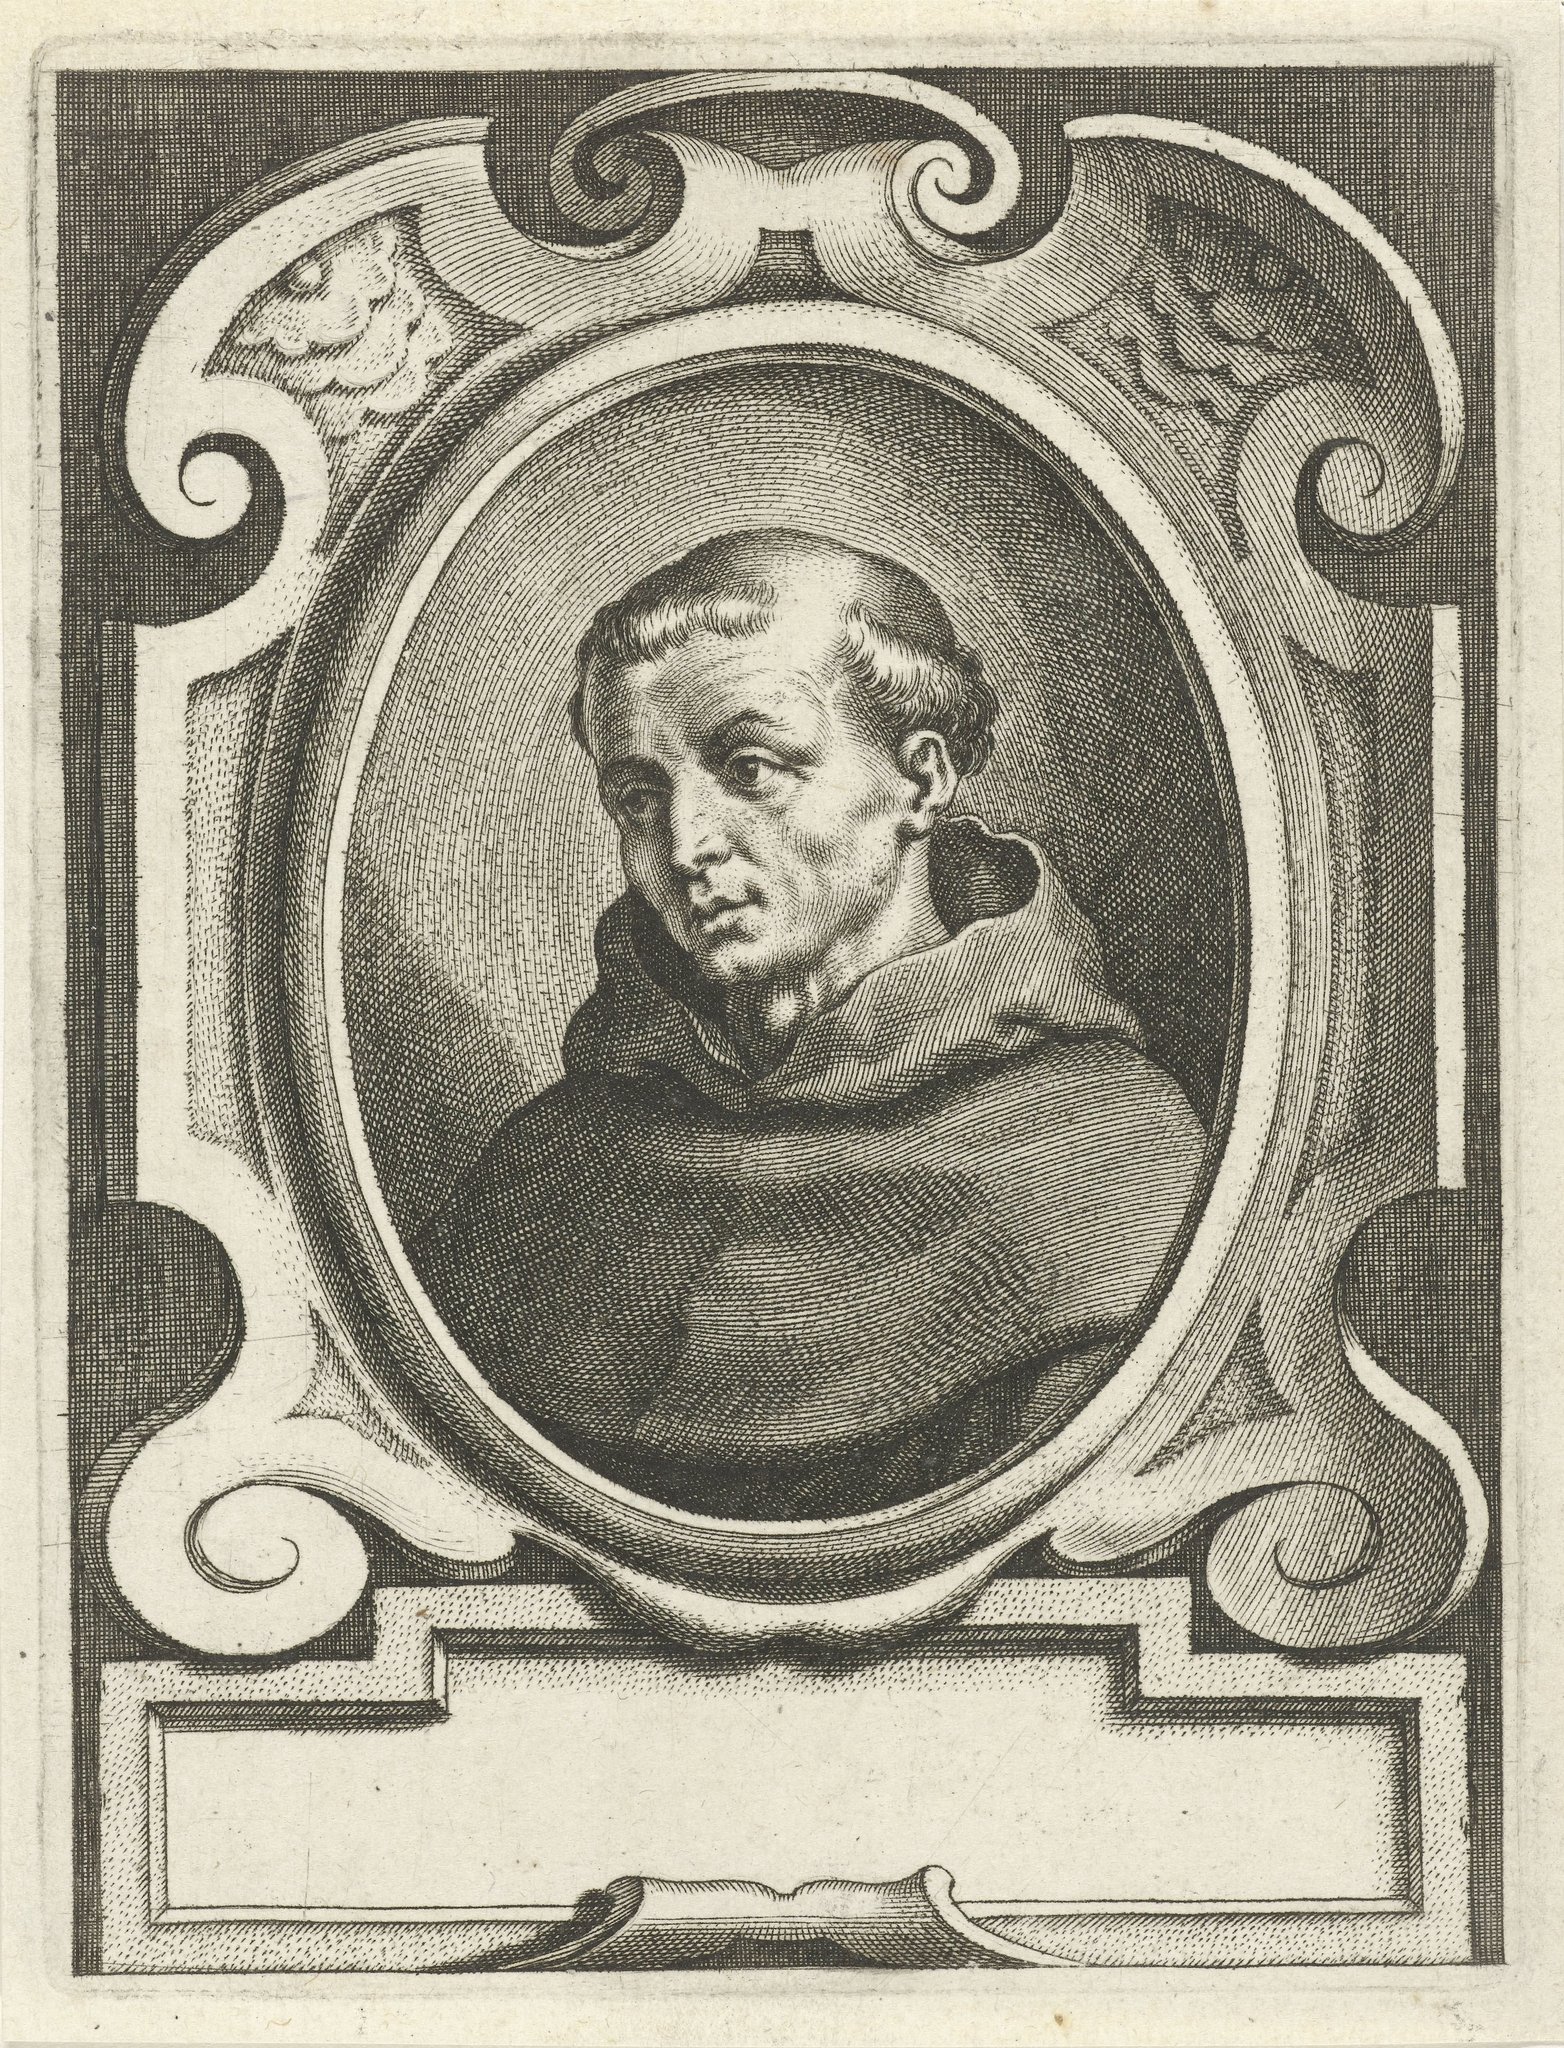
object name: print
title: Portret van de Augustijn Gregorius Ariminensis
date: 1636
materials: paper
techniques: engraving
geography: southern netherlands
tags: monastic orders, monastic life ~ roman catholic church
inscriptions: collector's mark: Lugt 2228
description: Boekillustratie voor: C. Curtius, Virorum illustrium ex ordine Eremitarum D. Augustini elogia , Antwerpen: J. Cnobbaert, 1636.